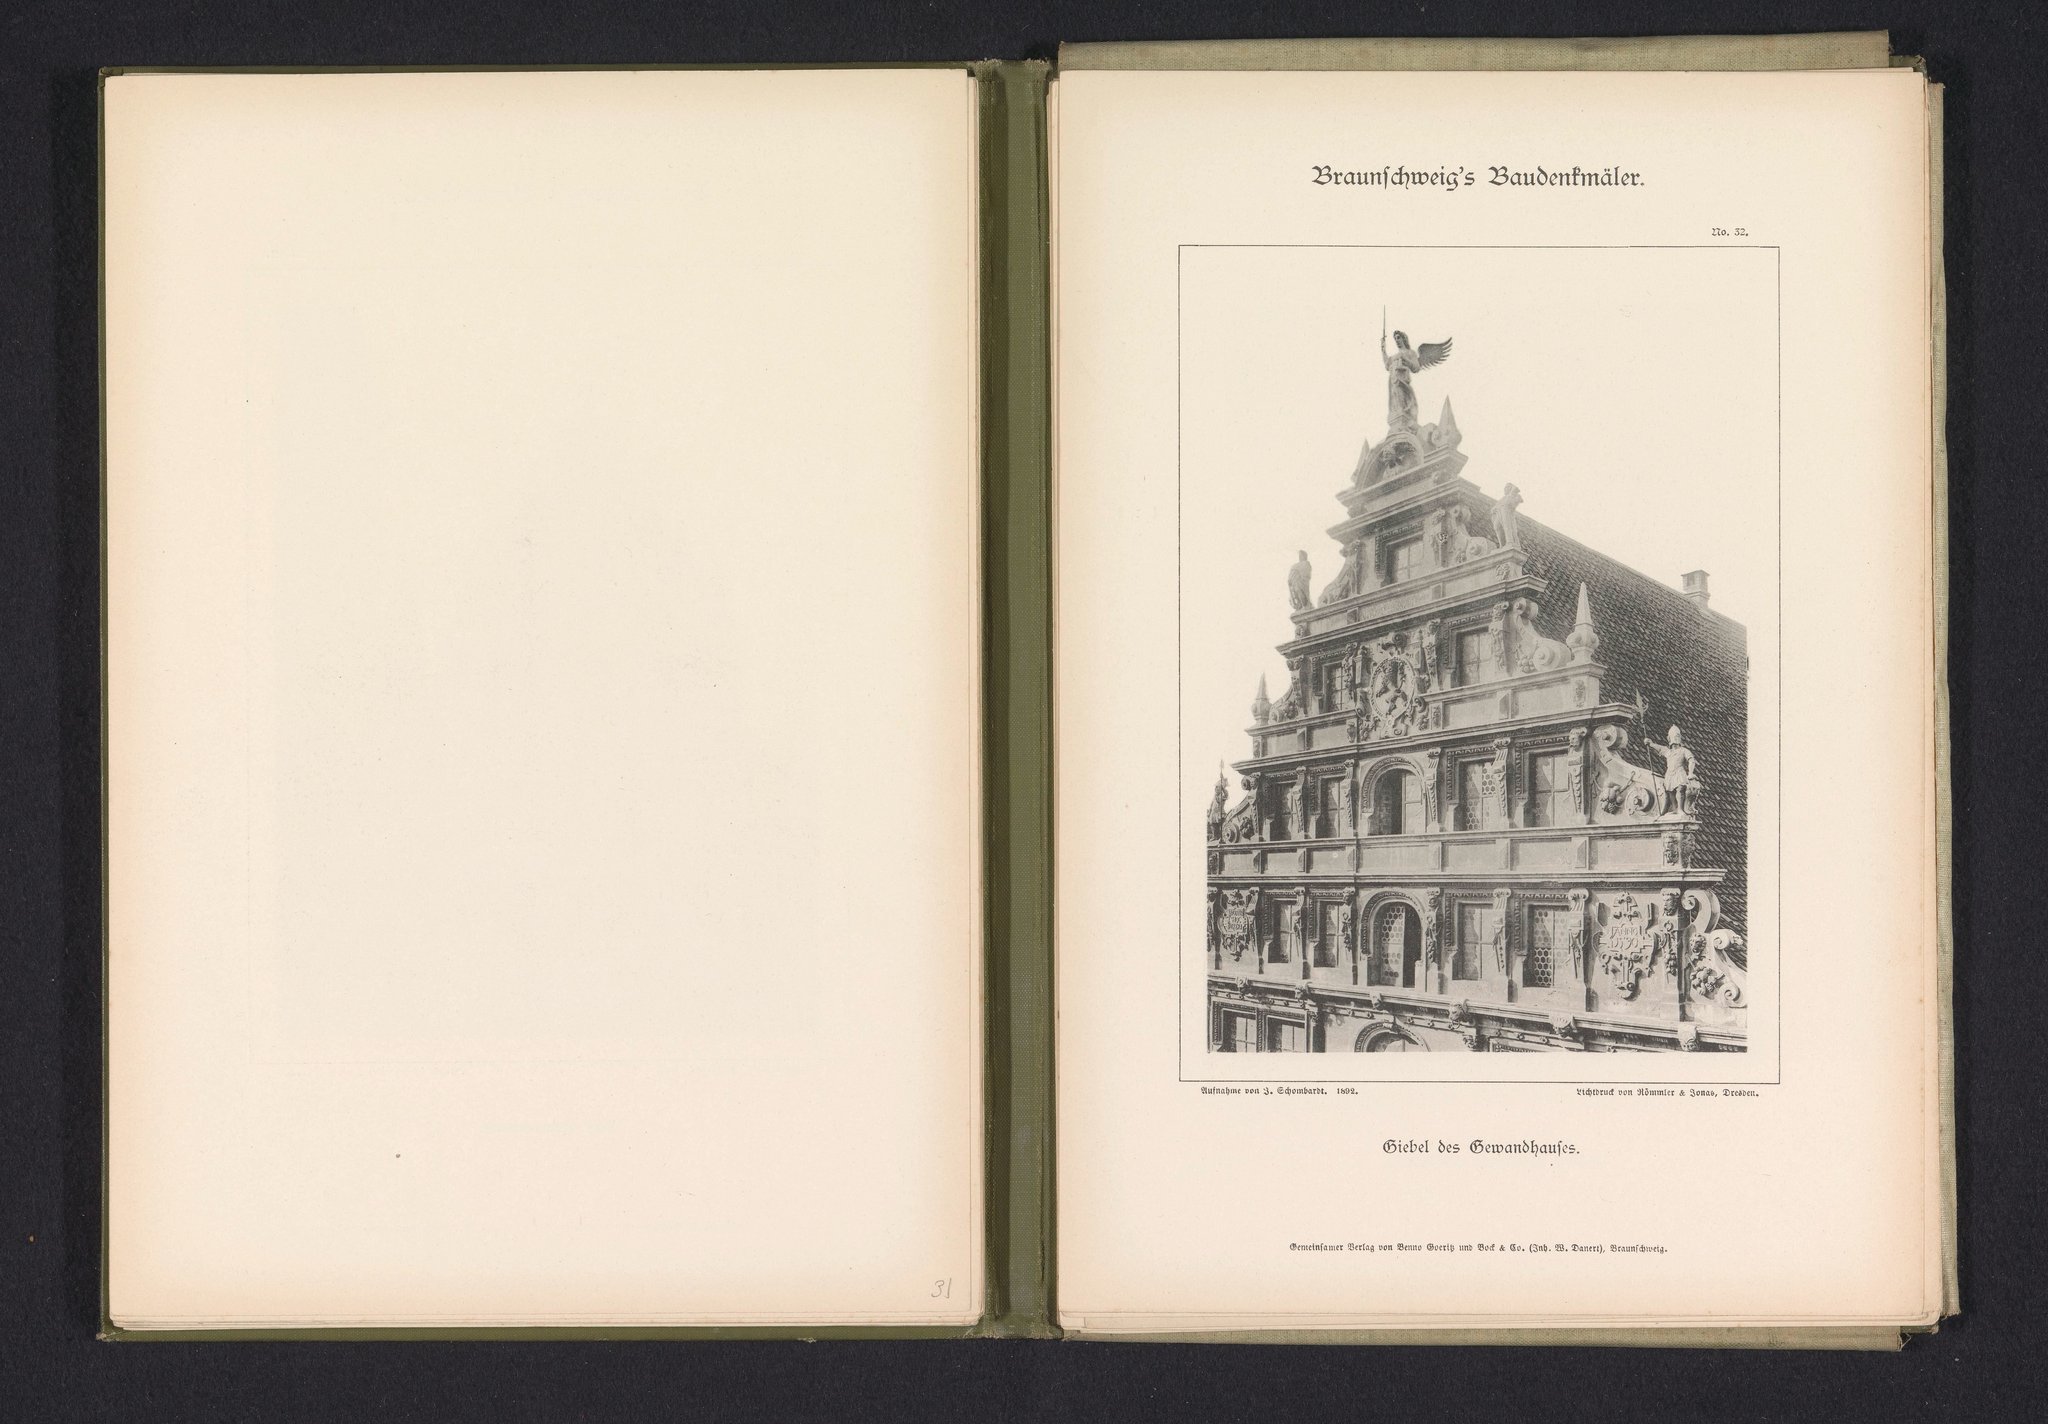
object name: page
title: Braunschweig's Baudenkmäler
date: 1892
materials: paper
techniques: photograph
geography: dresden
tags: guildhall, façade (of house or building)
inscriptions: number: ‘No. 32.’